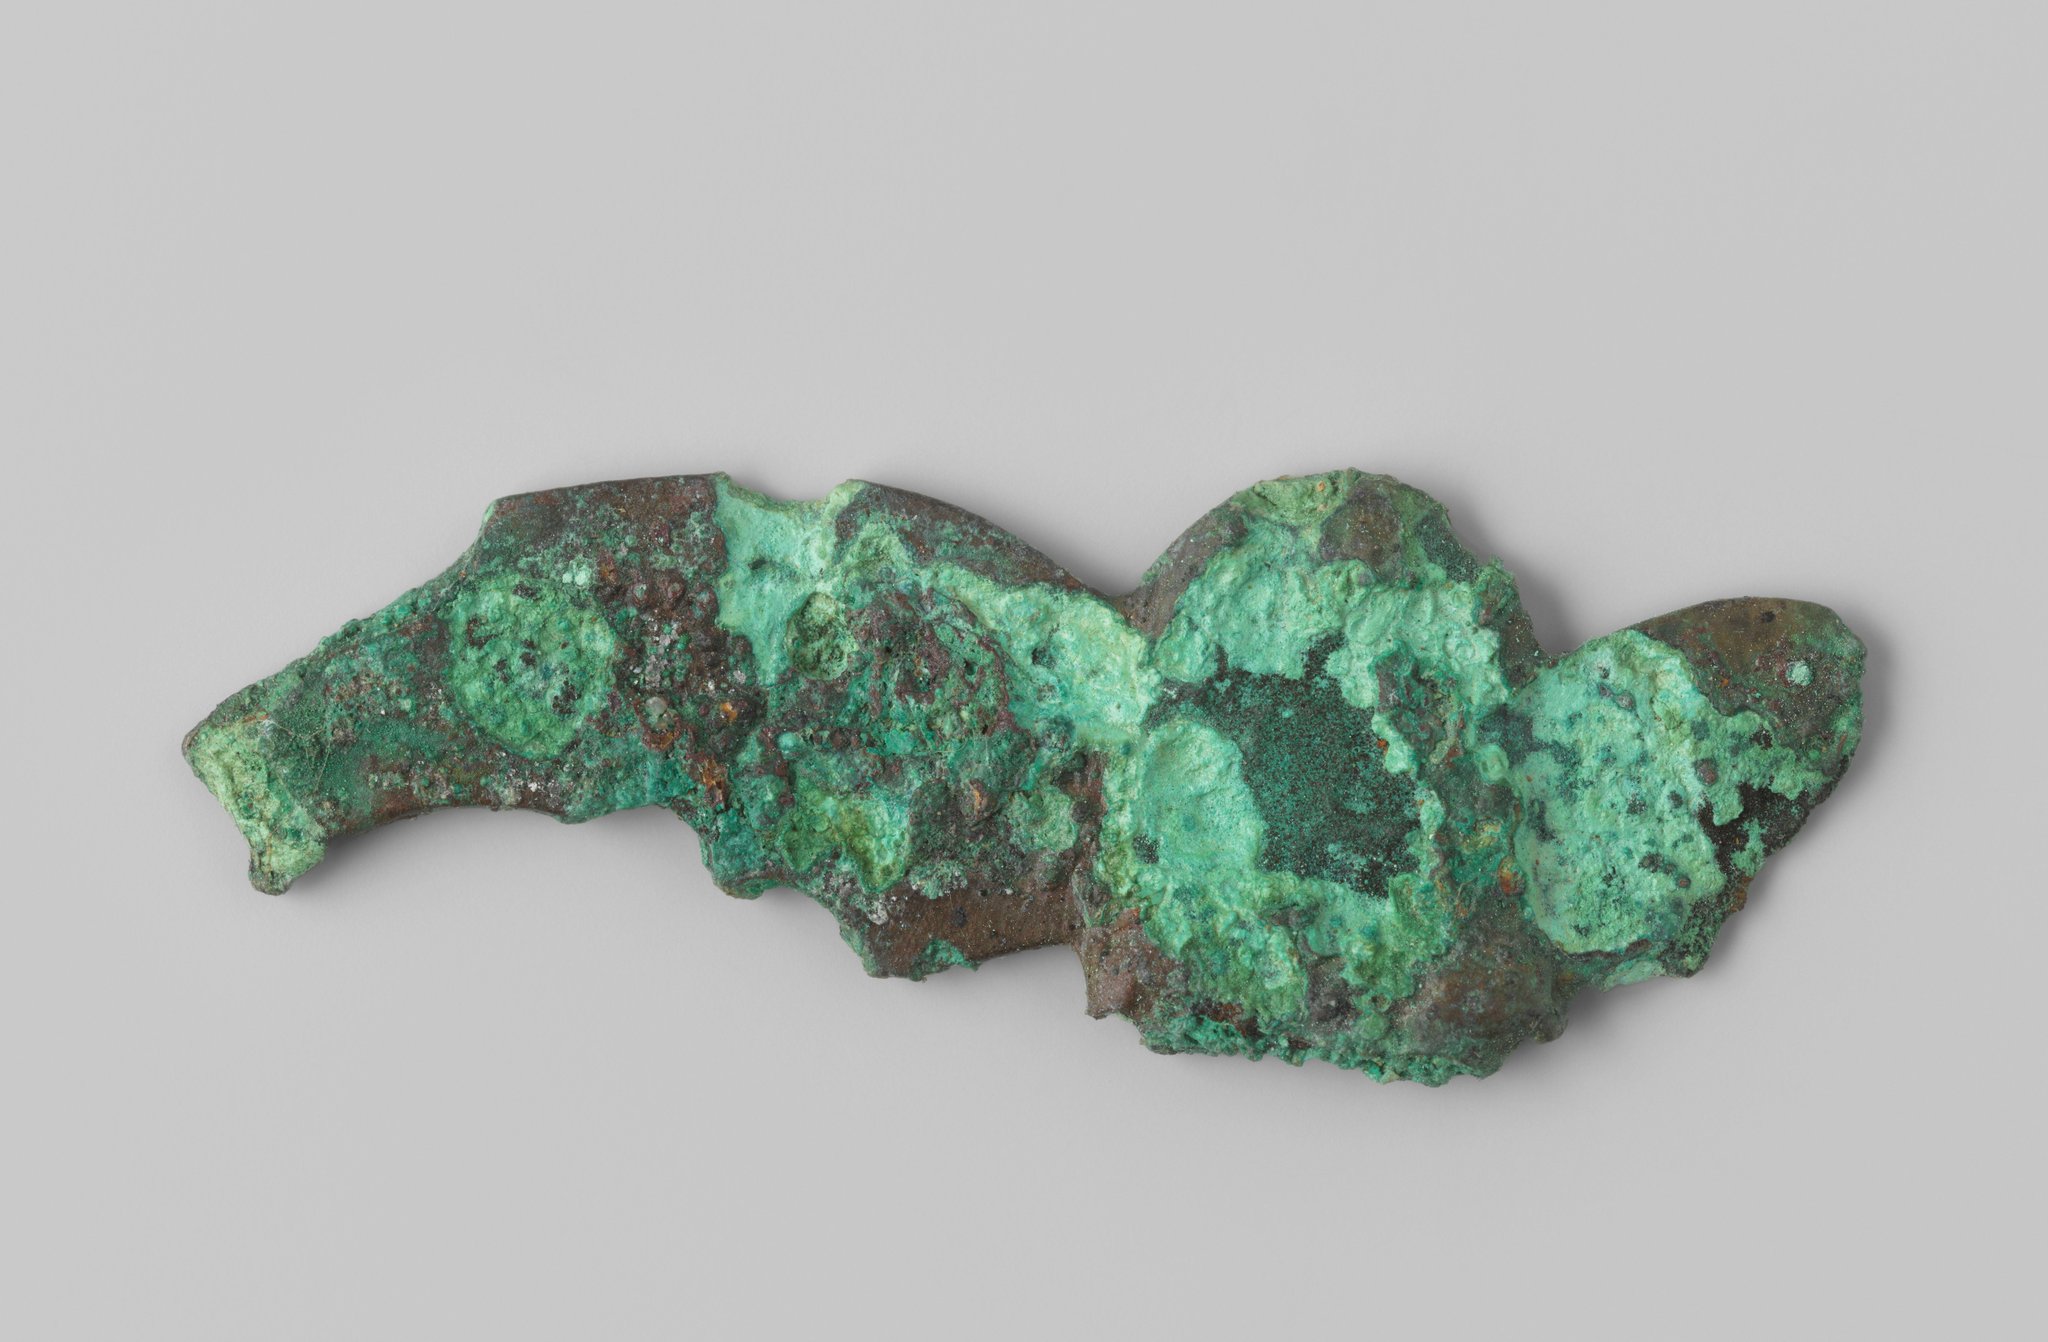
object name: musket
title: Fragment schroefplaat van een musket uit het wrak van de Oost-Indiëvaarder Hollandia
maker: Anonymous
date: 1700-1743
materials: copper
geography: netherlands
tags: verenigde oostindische compagnie, hollandia (schip), annet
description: Fragm, id. NG 1978-74H986 or NG 1980-27H3069, left wing and right eye broken off, heavily eroded, side plate.